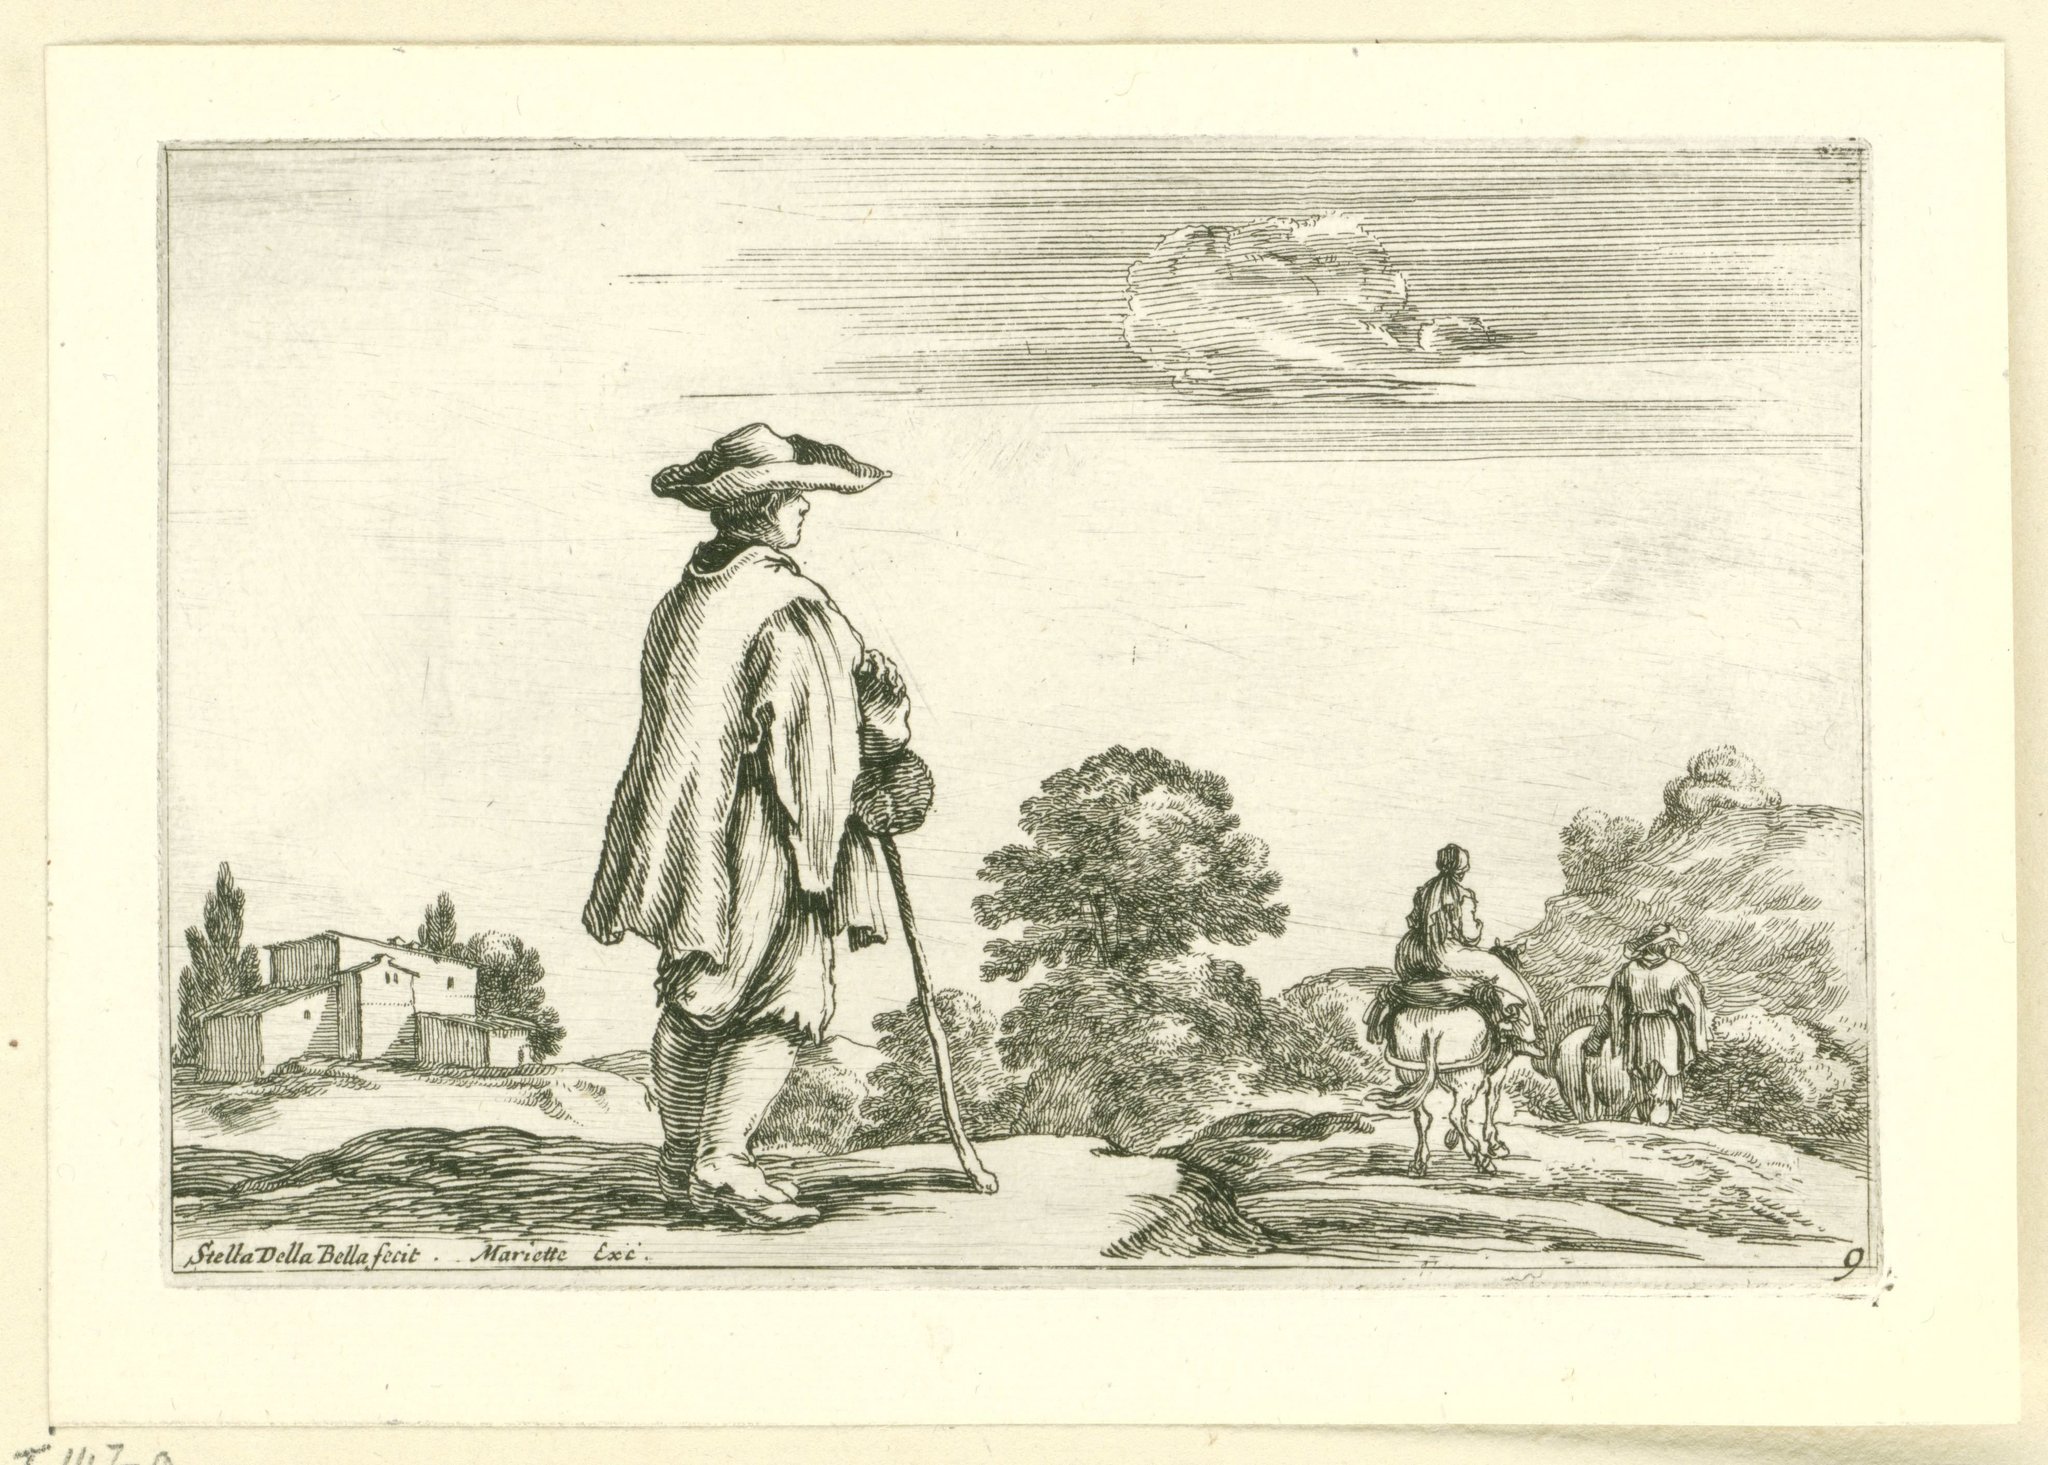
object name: print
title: Twaalf landschappen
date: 1620-1664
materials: paper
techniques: etching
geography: france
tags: walking, hiking (recreation), landscapes, farmers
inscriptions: collector's mark: Lugt 240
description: Een landschap met op de voorgrond een man, leunend op zijn stok. Op de achtergrond links huizen. Op de achtergrond rechts een man met een paard en een vrouw te paard.